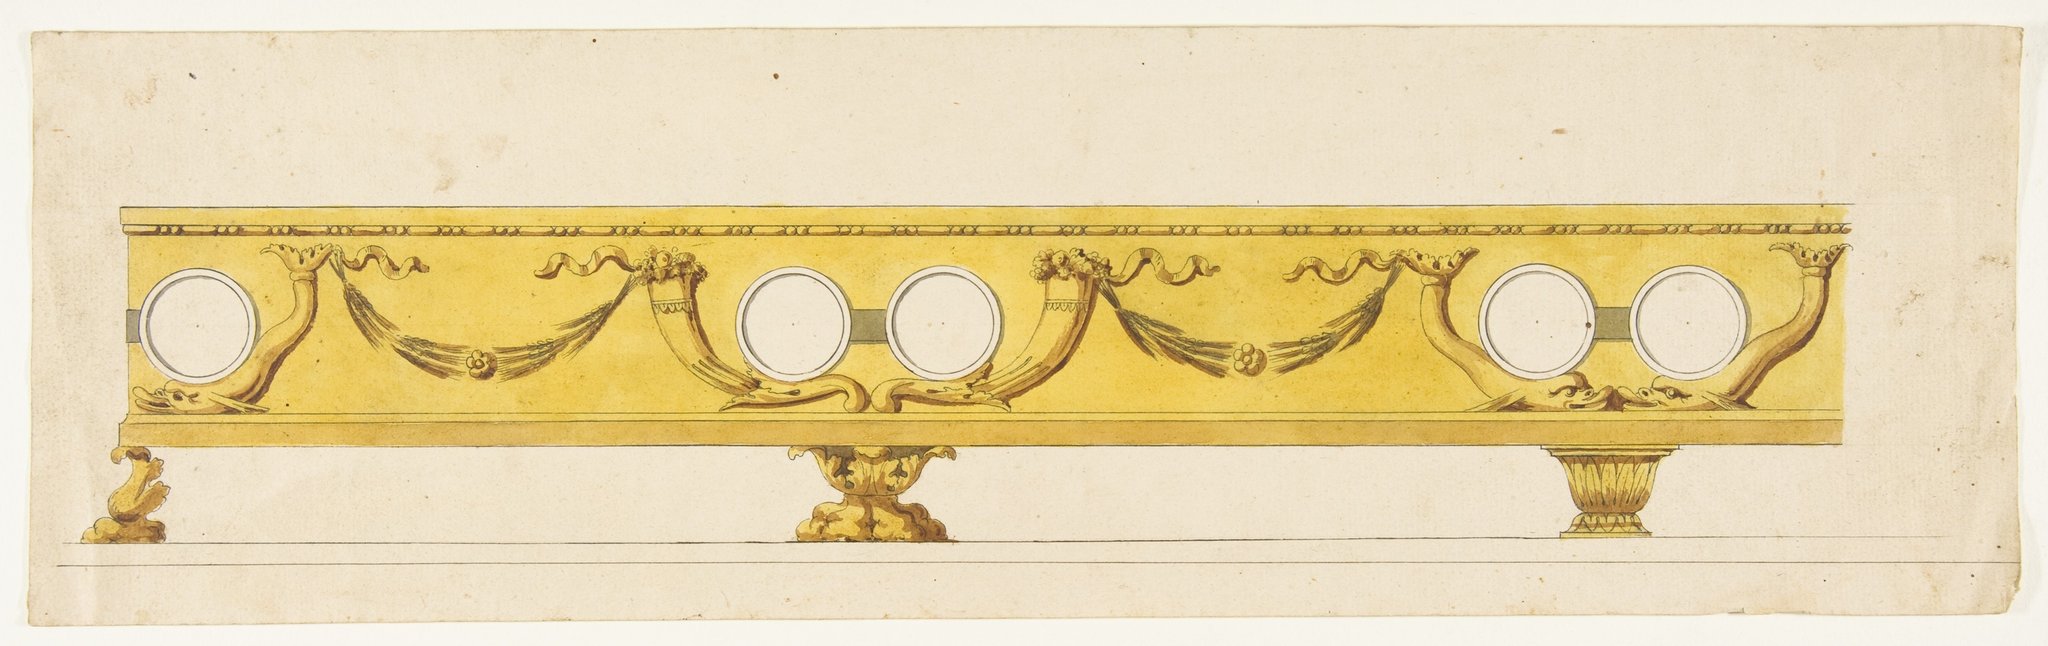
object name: drawing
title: Ornament Design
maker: anonymous, french, 19th century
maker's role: artist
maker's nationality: french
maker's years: 1800-1900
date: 1801-1900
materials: ink, paper, watercolor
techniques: pen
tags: ornament